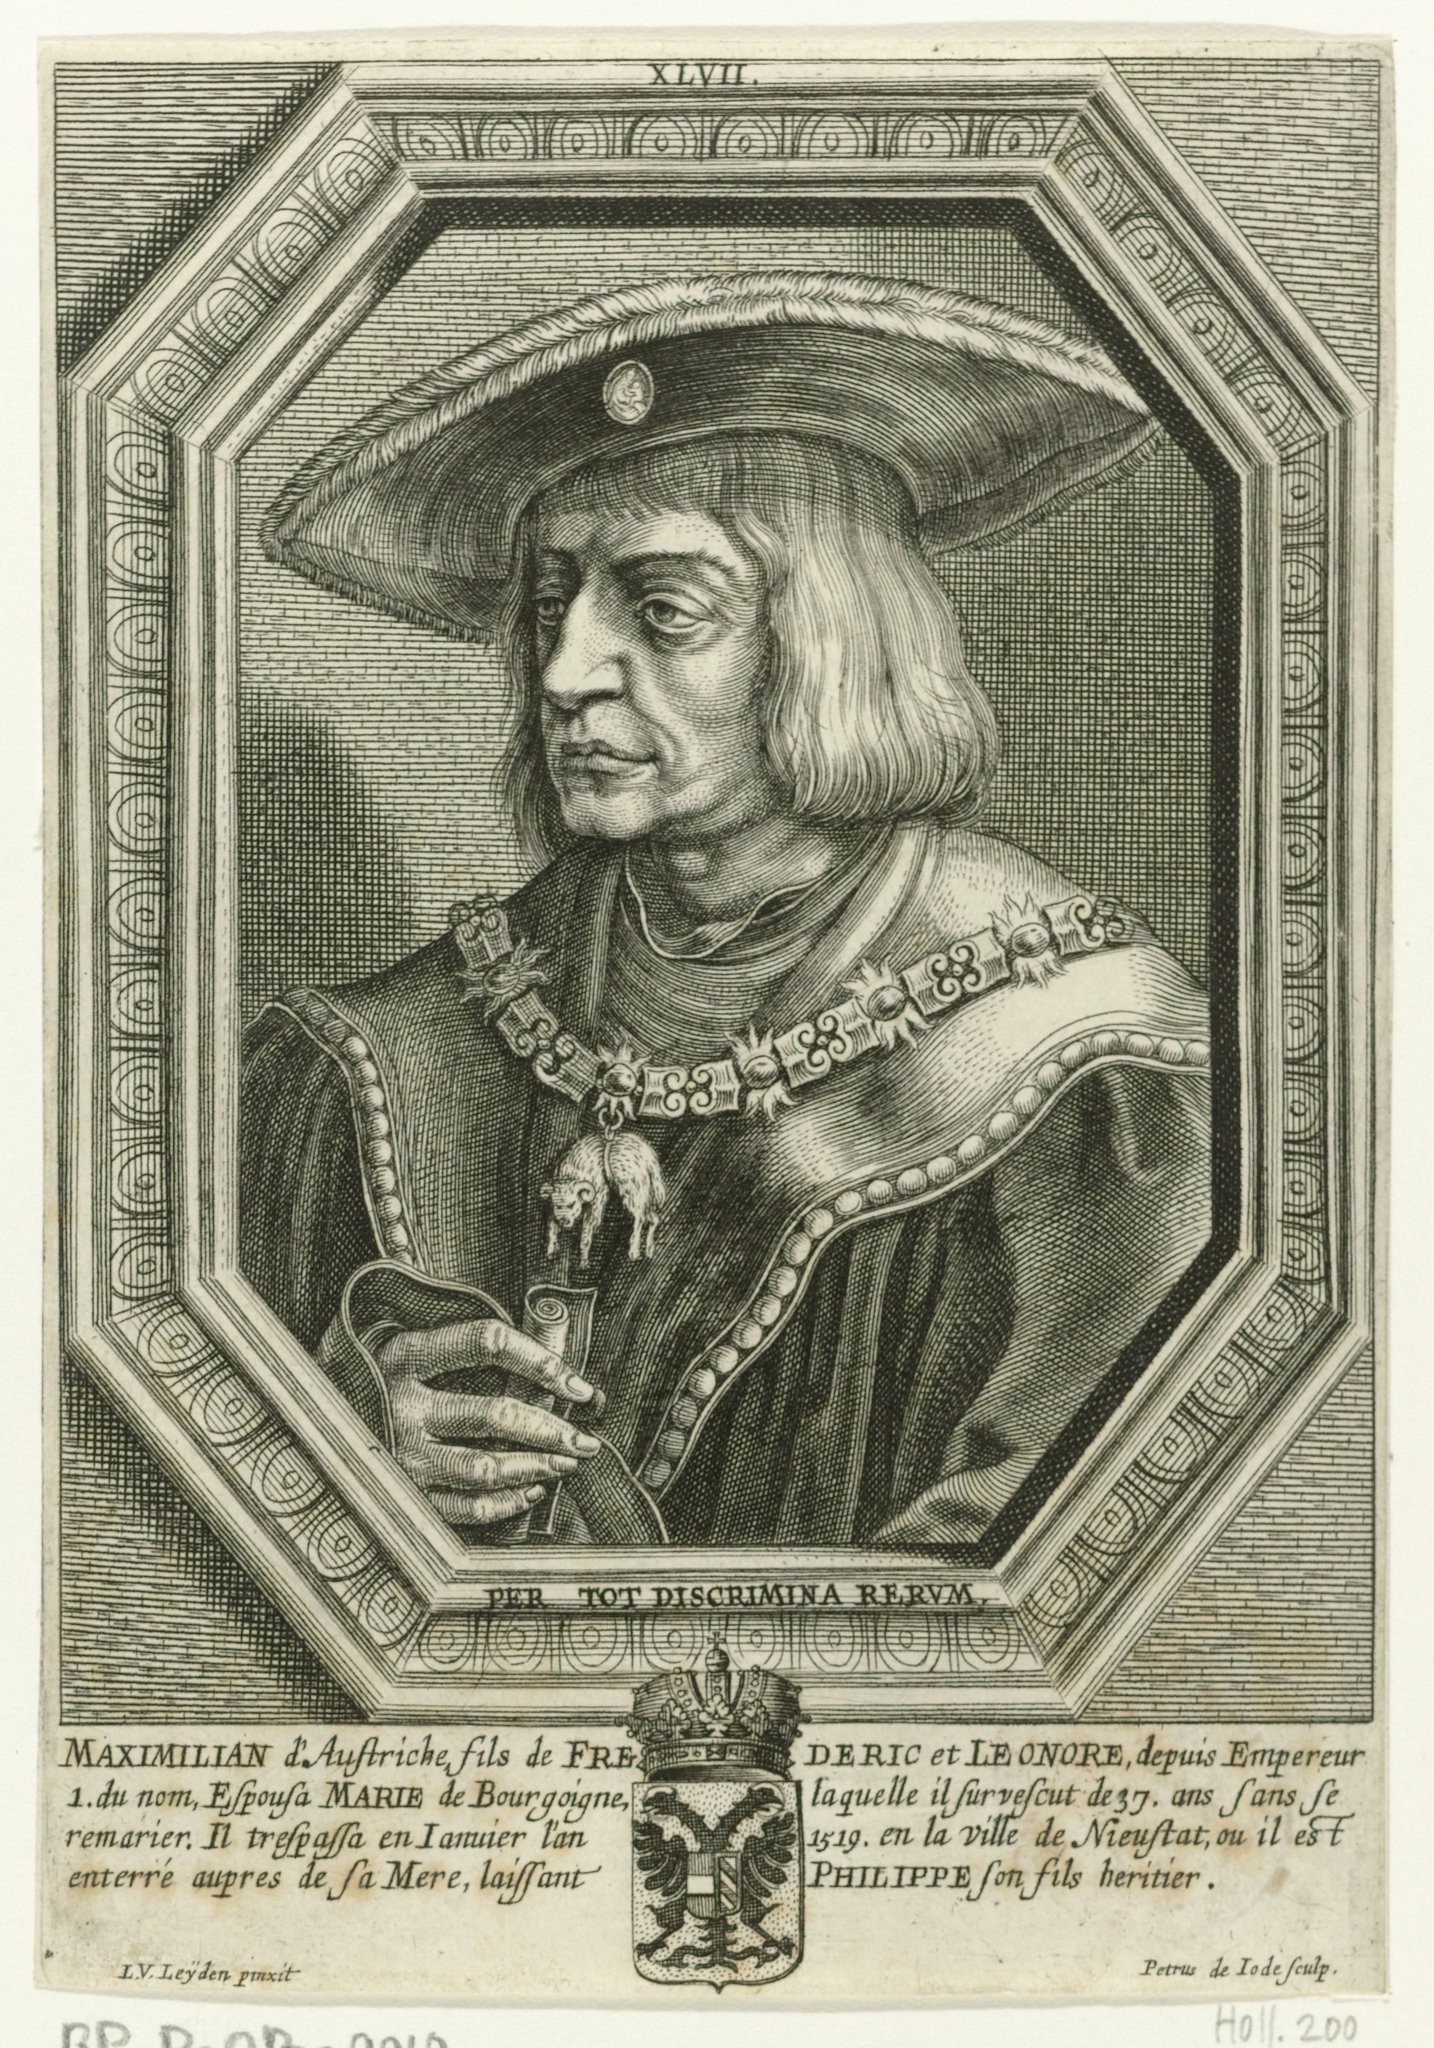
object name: print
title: Portret van keizer Maximiliaan I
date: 1661-1663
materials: paper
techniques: engraving, etching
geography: antwerp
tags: maximilian i (holy roman emperor), knighthood order of the golden fleece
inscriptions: collector's mark: Lugt 240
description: Busteportret van Maximiliaan I van Oostenrijk, met baret. Hij draagt een keten met de Orde van het Gulden Vlies. In zijn rechterhand houdt hij een opgerold vel papier. Het portret is gevat in een achthoekige omlijsting met een motto in het Latijn. In de marge het wapenschild van de geportretteerde en een vierregelig onderschrift in het Frans. Prent uit een boek waarin 54 prenten met portretten.